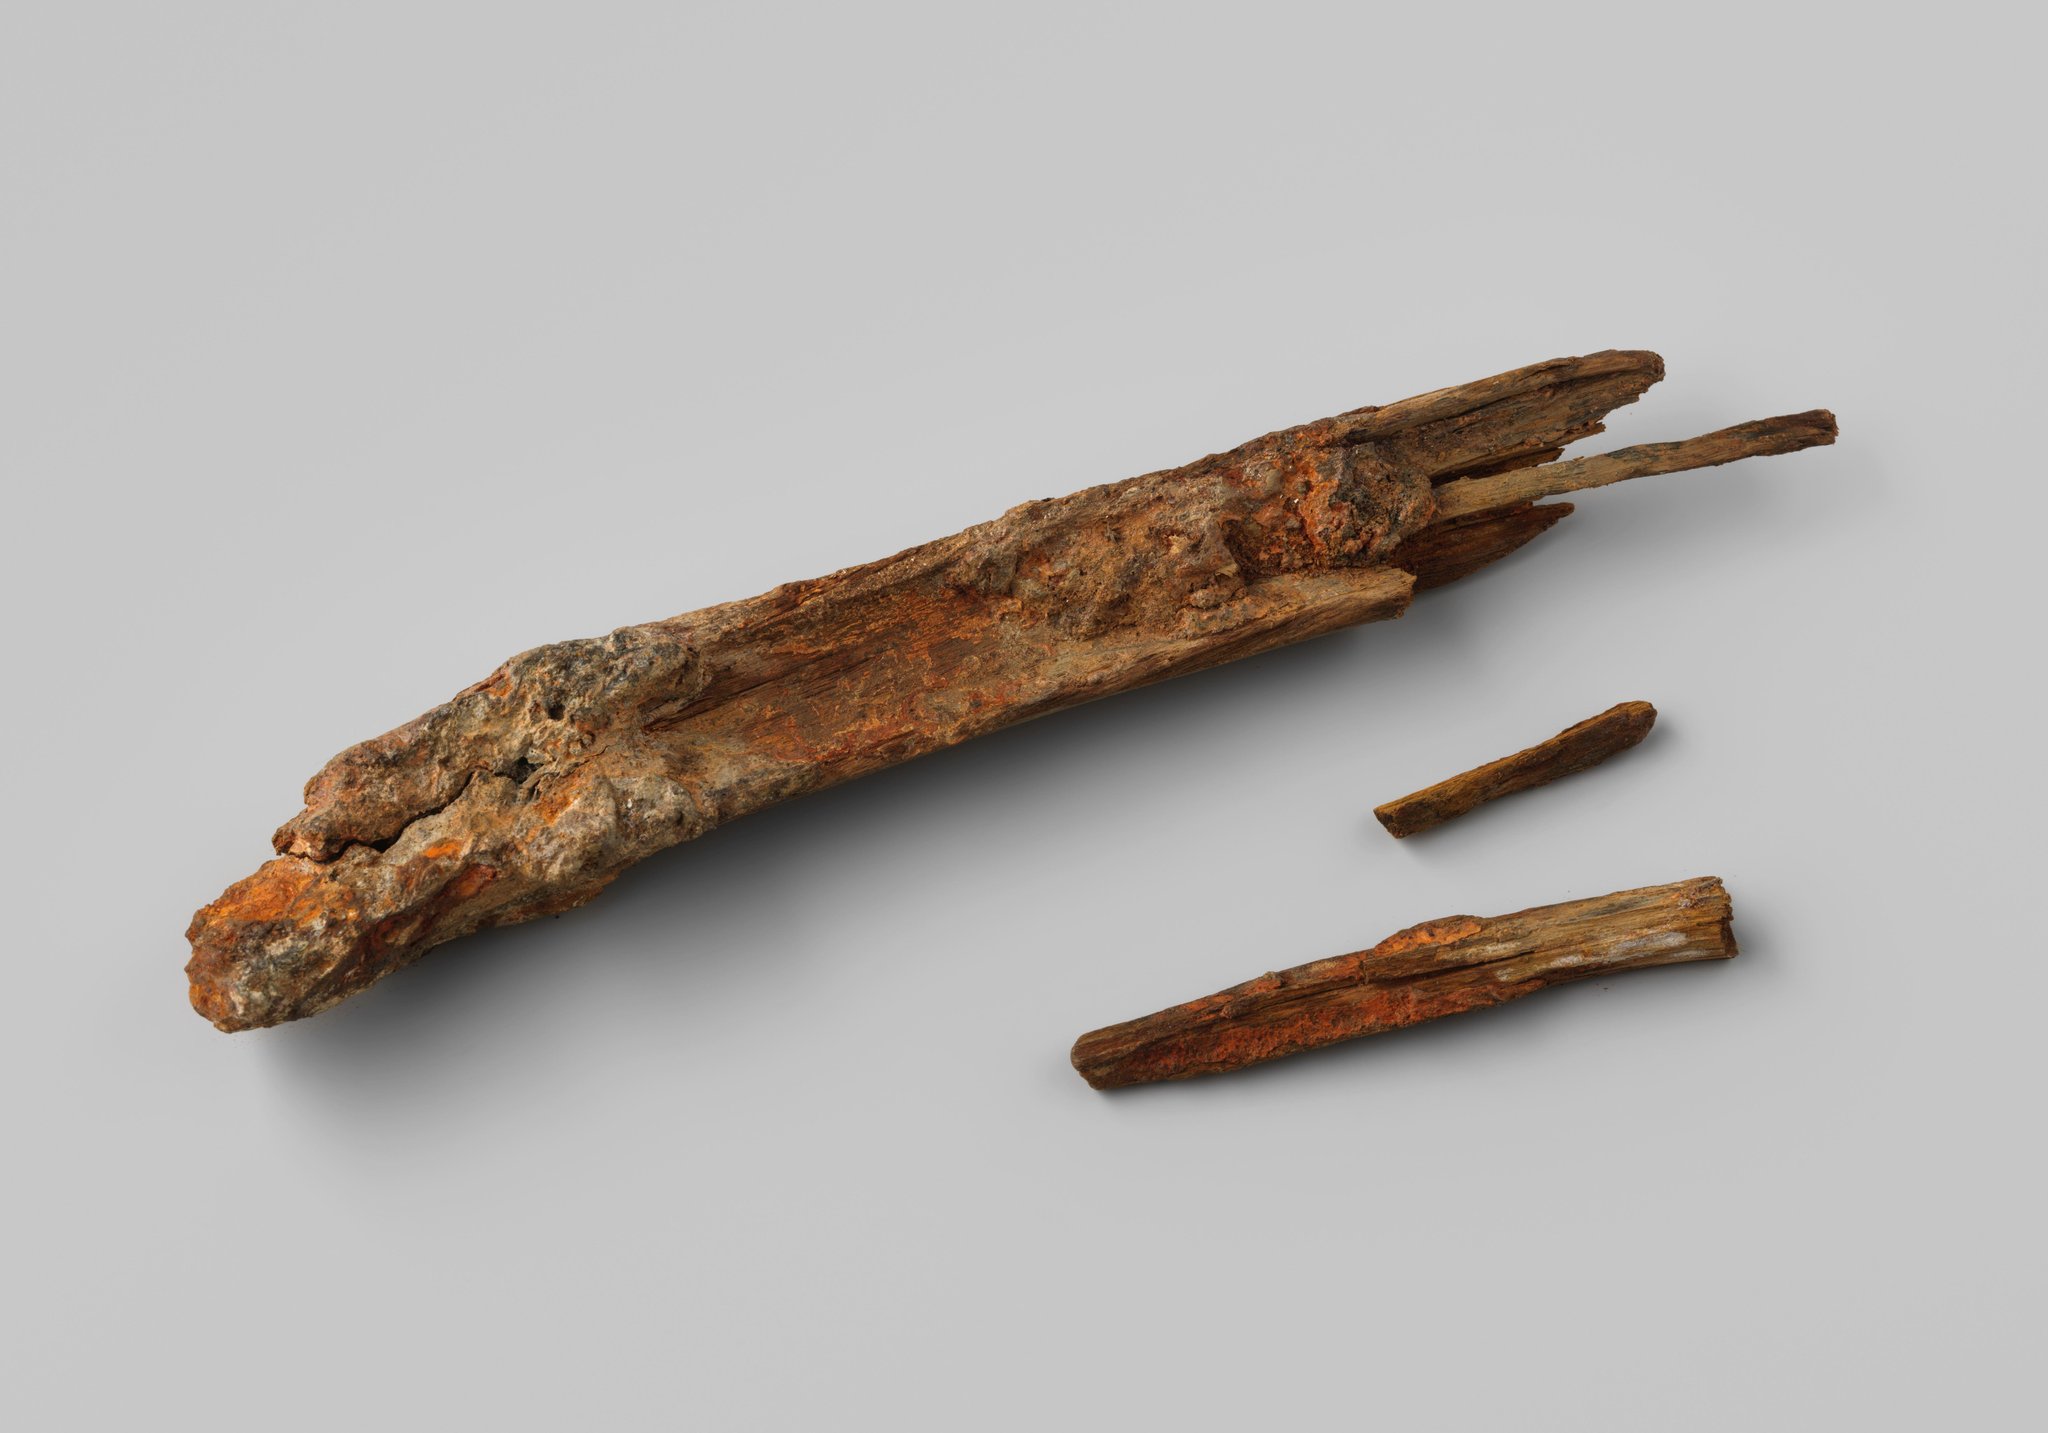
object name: rammer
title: Laadstok met concretie van een musket uit het wrak van de Oost-Indiëvaarder Hollandia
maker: Anonymous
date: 1700-1743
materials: stone, copper, wood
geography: netherlands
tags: verenigde oostindische compagnie, hollandia (schip), annet